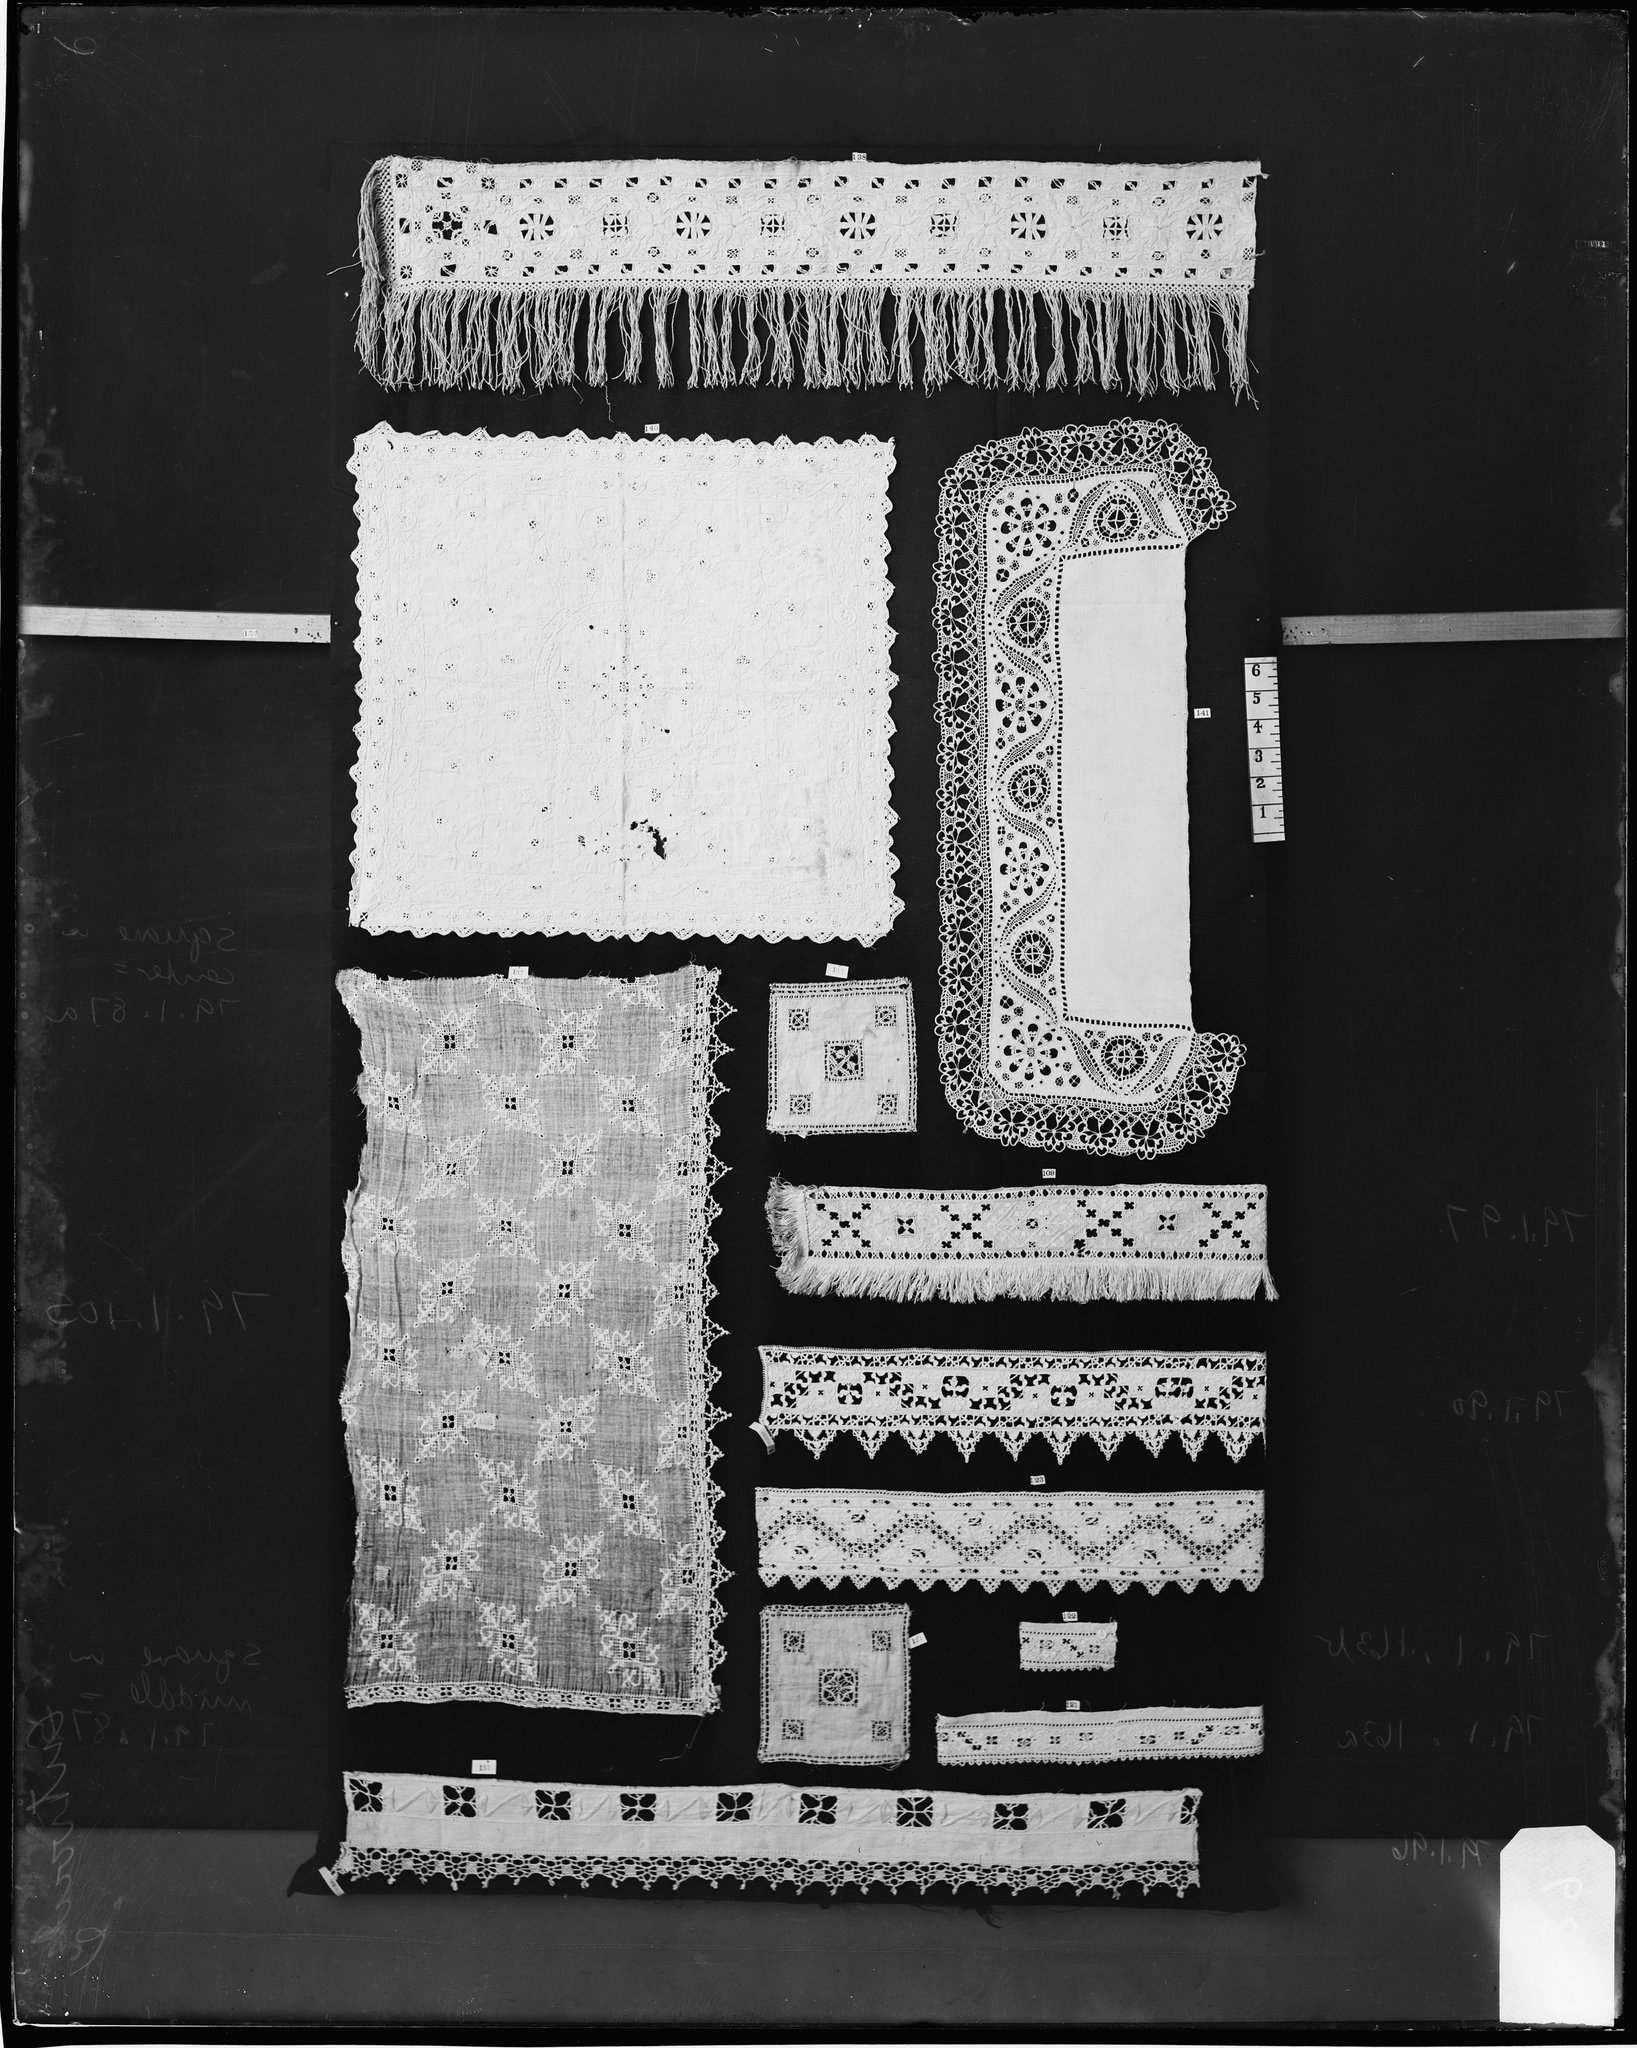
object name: border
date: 1501-1600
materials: linen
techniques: embroidery